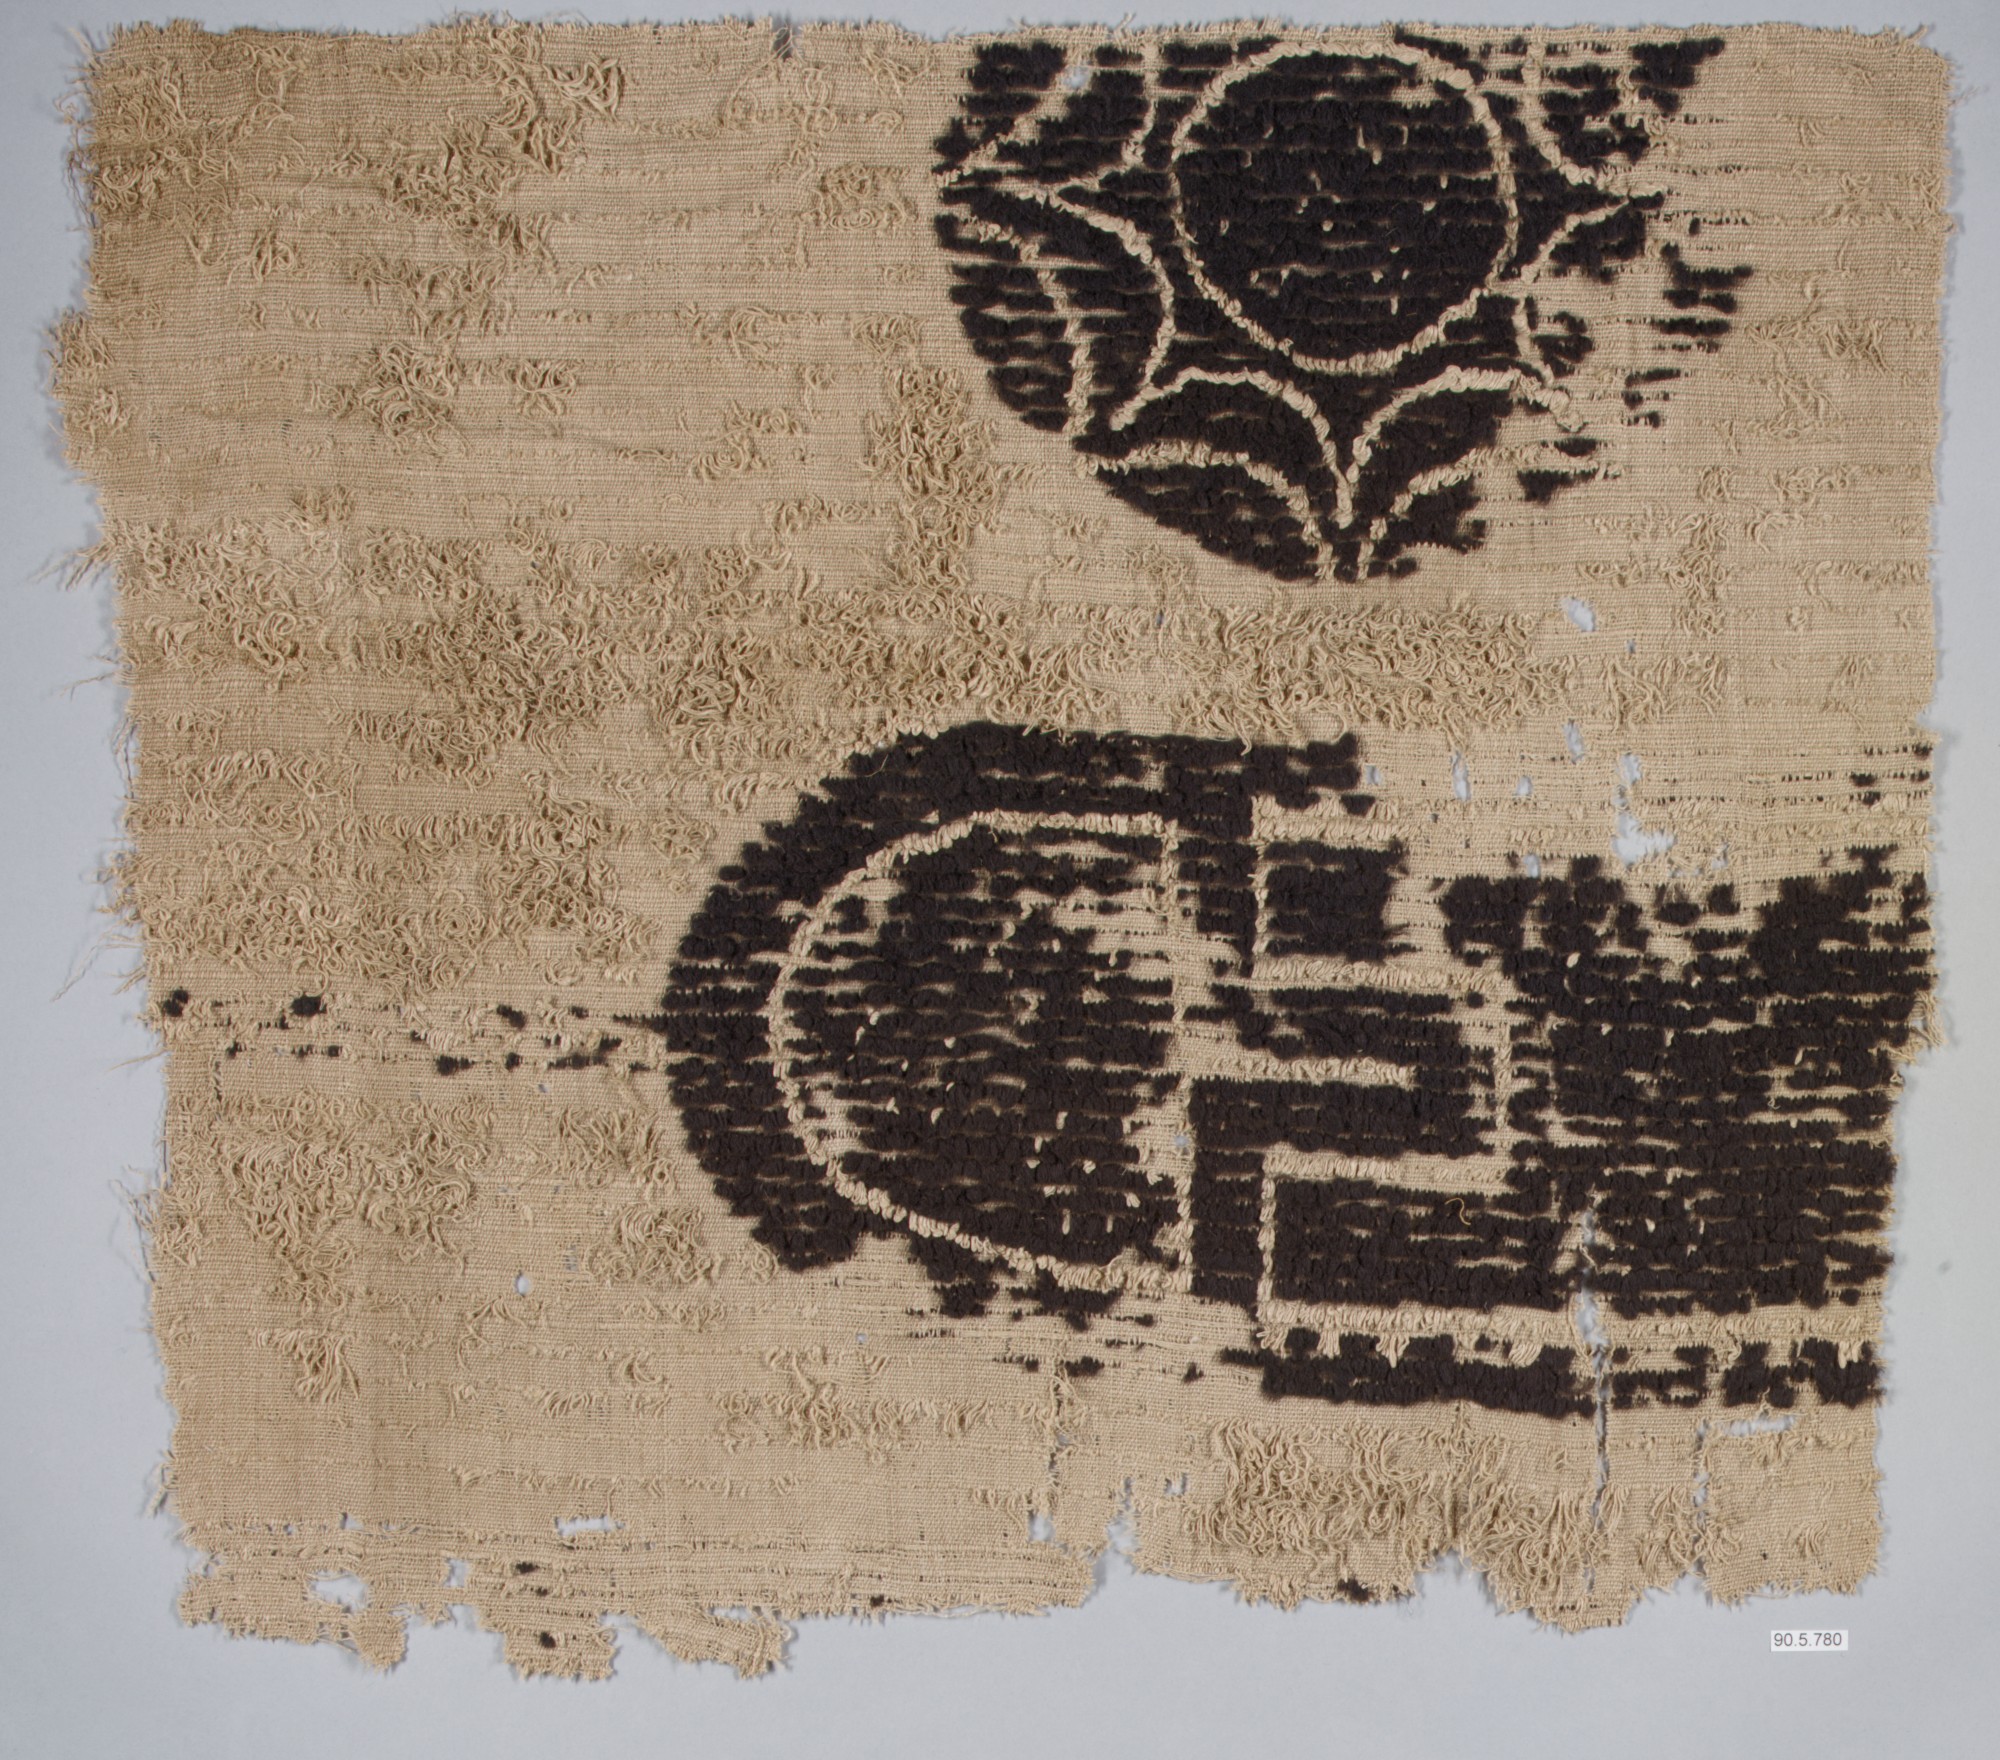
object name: textile fragment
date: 201-400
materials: linen, wool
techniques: weave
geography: egypt